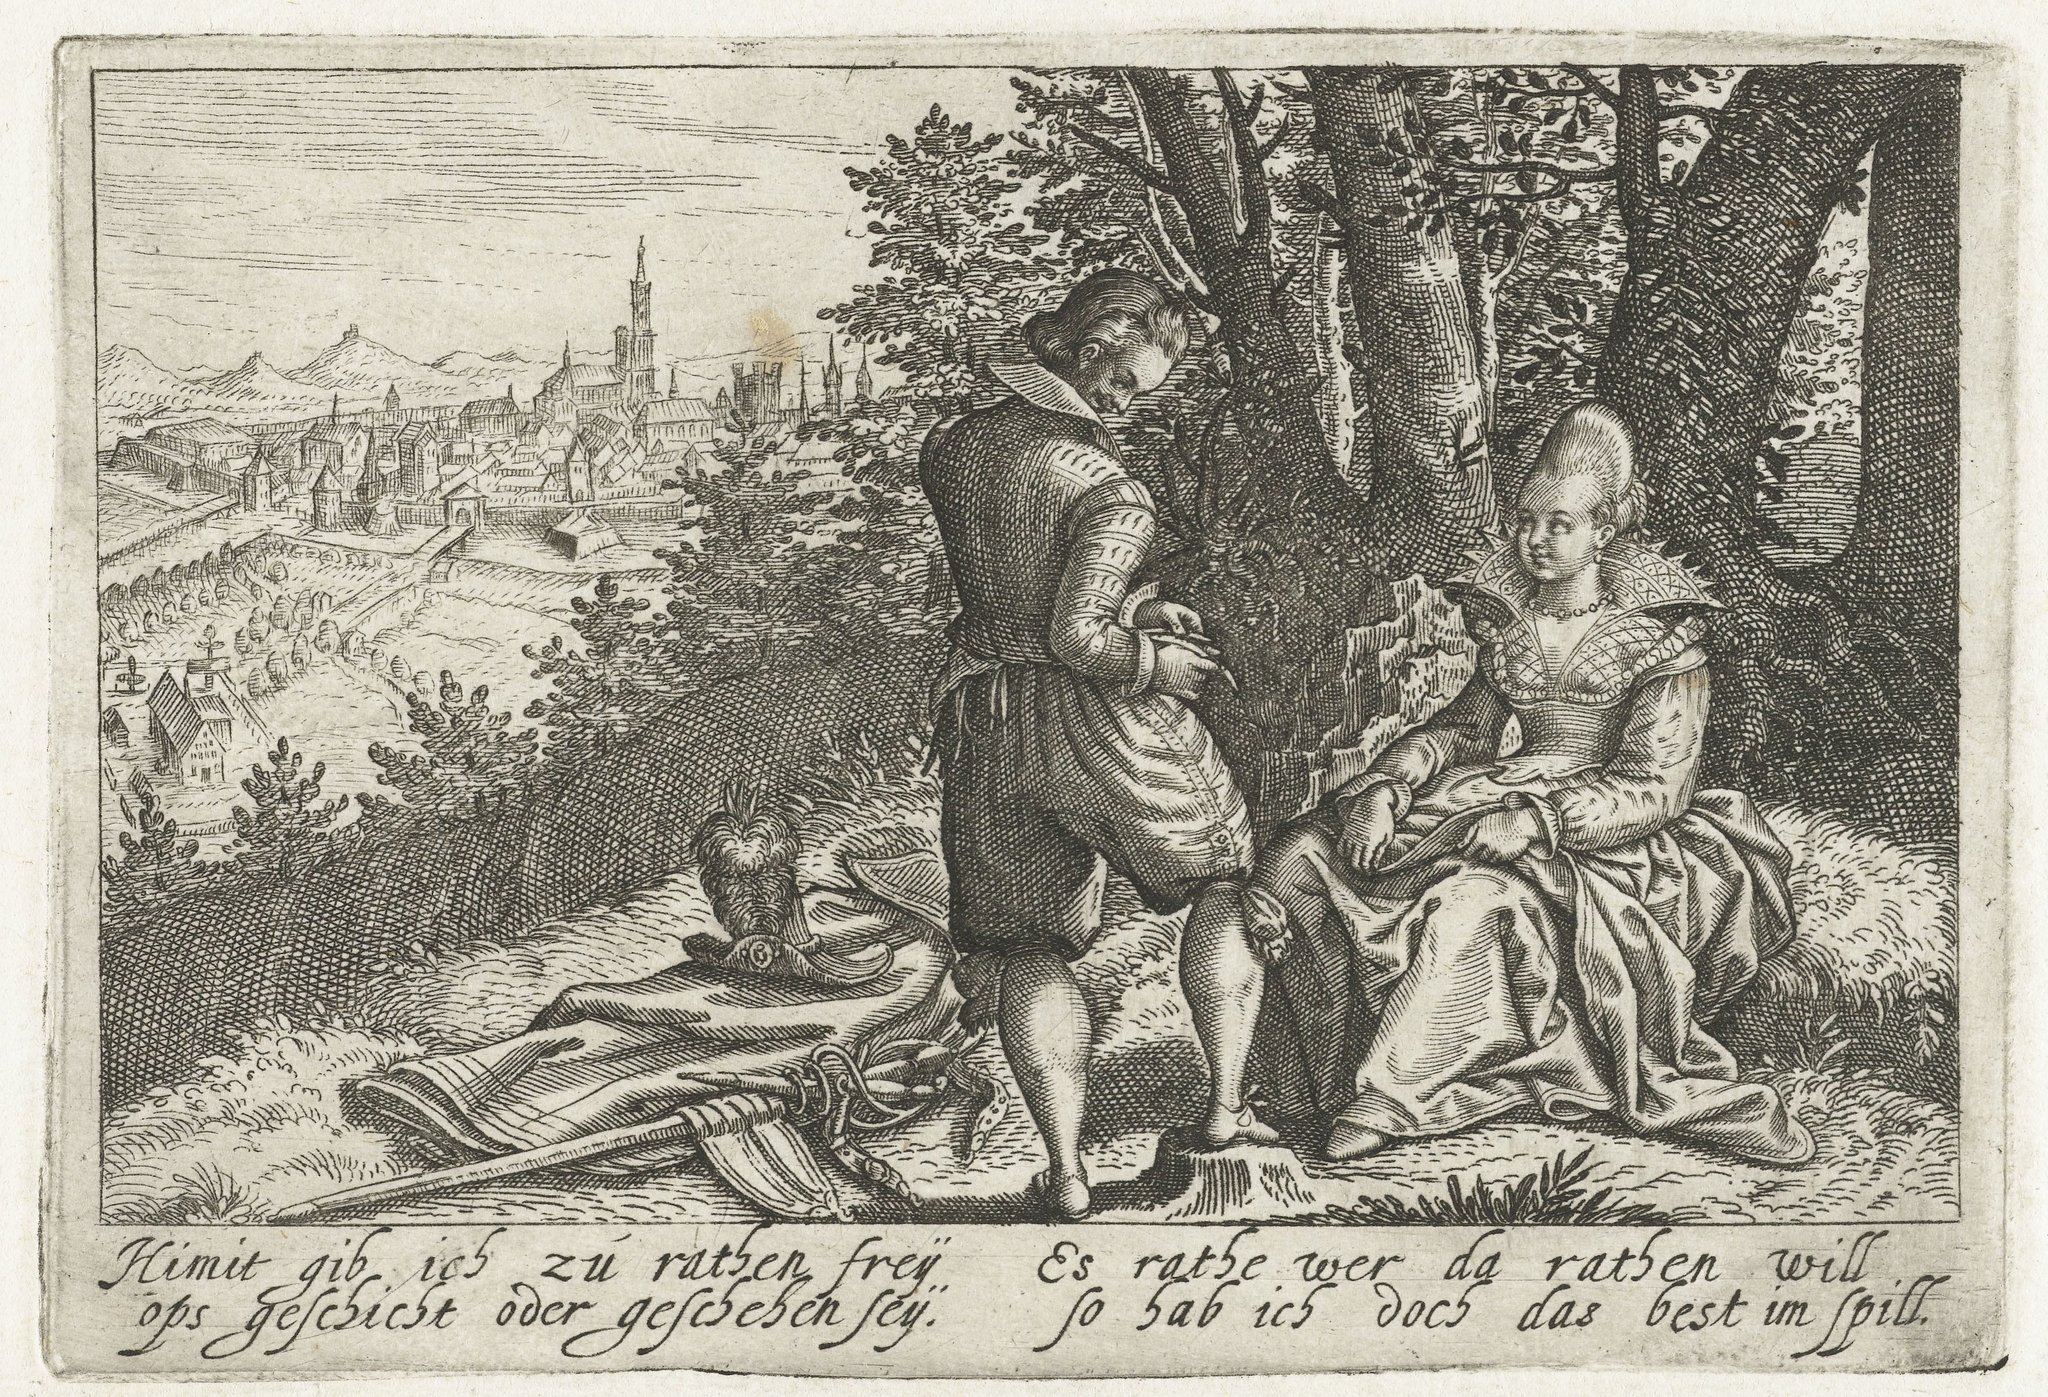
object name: print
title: Landschap met liefdespaar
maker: jacob van der heyden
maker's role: draughtsman, print maker, publisher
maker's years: 1573-1645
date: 1608-1618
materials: paper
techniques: engraving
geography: straatsburg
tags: city-view, and landscape with man-made constructions, 'album amicorum', 'stammbuch', morality, undressing oneself, getting undressed, lovers' meeting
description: Deze serie, getiteld ‘Pugillus facetiarum iconographicarum in studiosorum (…)’, bestond vermoedelijk uit 36 of meer prenten. Van deze serie zijn in ieder geval twee uitgaven bekend, uit 1608 en 1618. De prenten uit deze serie in de collectie van het Rijksmuseum (RP-P-1996-1 t/m RP-P-1996-36) zijn vermoedelijk afkomstig uit verschillende uitgaven, of uit de tweede uitgave. De inhoud van beide uitgaven verschilt, maar om de precieze inhoud van de verschillende uitgaven vast te stellen is meer onderzoek nodig. Er zijn geen volledige exemplaren van de eerste uitgave bekend. Aan de hand van de analyse van een andere serie, ‘Jeucht spieghel’,* die kopieën van ‘Pugillus’ bevat en is uitgegeven in 1610 én de aanwezige exemplaren van prenten uit ‘Pugillus’ in een inmiddels verloren album amicorum uit 1610,** kan in ieder geval van een aantal prenten gesteld worden dat ze al voorkwamen in de uitgave van 1608. Dit geldt voor RP-P-1996-1 (de titelprent), RP-P-1996-5, RP-P-1996-6, RP-P-1996-7, RP-P-1996-8, RP-P-1996-9, RP-P-1996-10, RP-P-1996-11, RP-P-1996-12, RP-P-1996-13, RP-P-1996-14, RP-P-1996-15, RP-P-1996-16, RP-P-1996-17, RP-P-1996-18, RP-P-1996-19, RP-P-1996-24, RP-P-1996-28, RP-P-1996-29, RP-P-1996-33 en RP-P-1996-35. Van één prent (RP-P-1996-31) kan vastgesteld worden dat die pas in de latere uitgave van 1618 voorkwam, omdat het kopie is van een prent uit weer een andere serie, ‘Academia sive speculum vitae scholasticae (…)’, die werd uitgegeven in 1612.*** Van de huidige prent is onduidelijk of hij al voorkwam in de uitgave van 1608. * Z.G.H.P.H.S [Zacharias Heyns]. Jeucht spieghel. S.l.s.n., 1610. Voor een gedigitaliseerd exemplaar zie: https://archive.org/details/ned-kbn-all-00000628-001/page/n9/mode/2up. ** Zie: Erman, Wilhelm en Ewald Horn. Bibliographie der deutschen Universitäten, systematisch geordnetes Verzeichnis der bis Ende 1899 gedruckten Bücher und Aufsätze über das deutsche Universitätswesen. Leipzig en Berlijn: Verlag von B.G. Teubner, 1904, dl. 1, p. 826-832, no. 17328. https://archive.org/details/bibliographieder01ermauoft/page/826/mode/2up *** Passe, Crispijn van de (I). Academia sive speculum vitae scholasticae (…). Arnhem: Johannes Janssonius [Jan Jansz.], 1612. Voor een gedigitaliseerd exemplaar zie: http://gallica.bnf.fr/ark:/12148/btv1b55005974h.